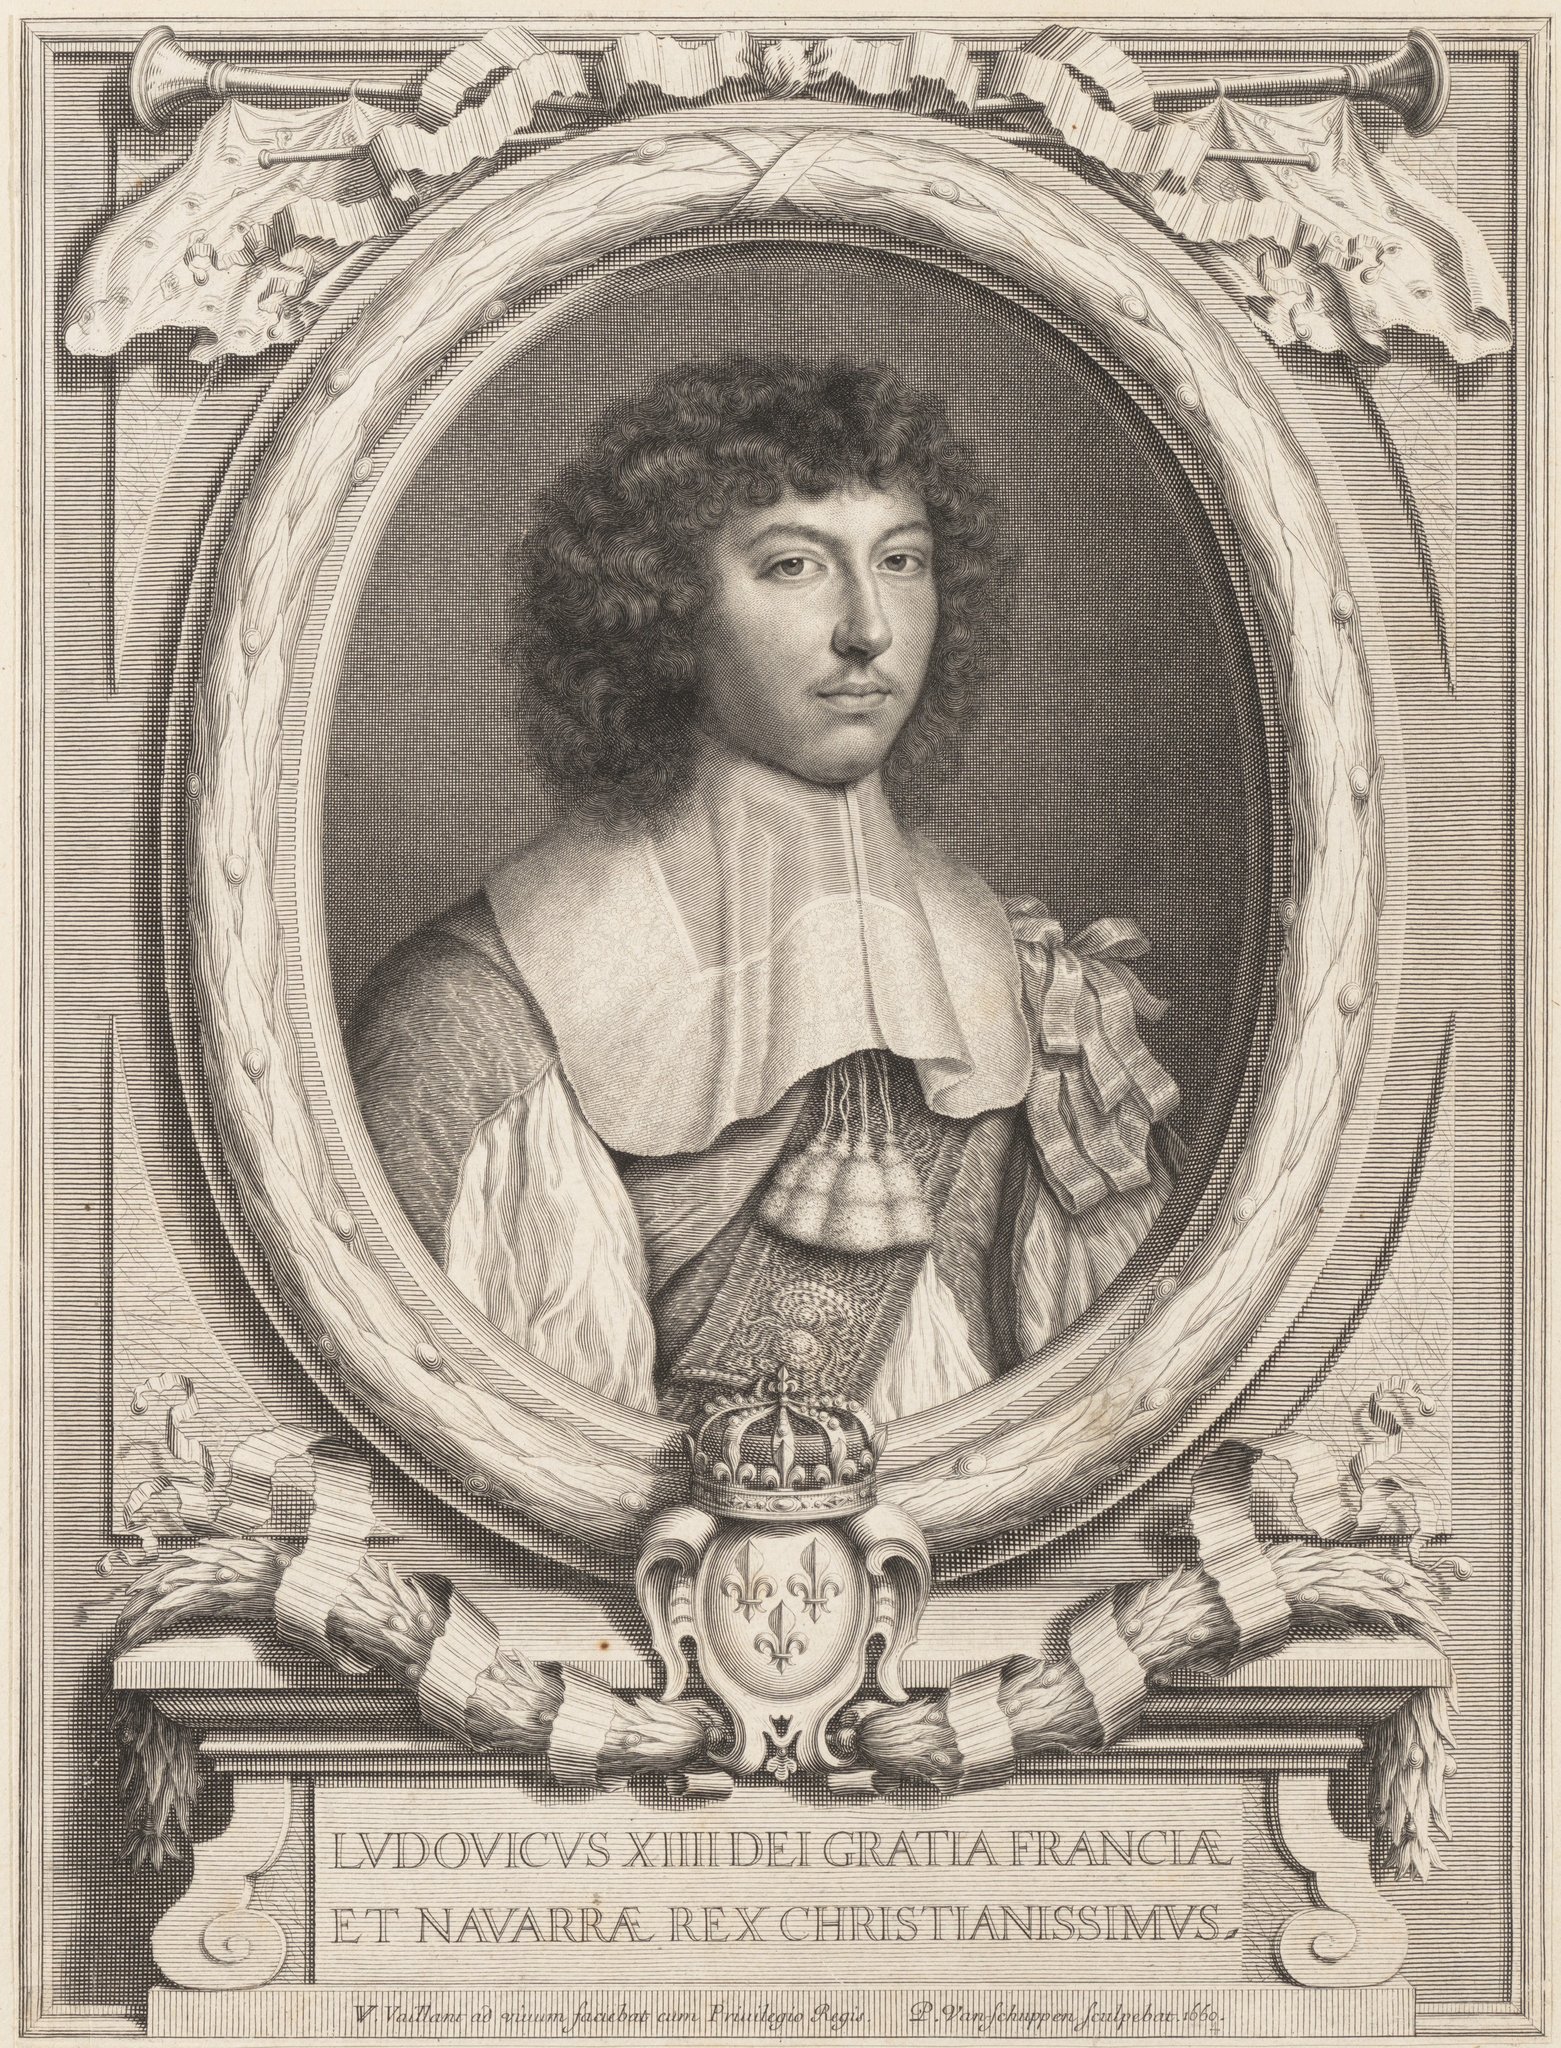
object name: print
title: Portrait of Louis XIV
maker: pieter van schuppen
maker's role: artist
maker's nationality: flemish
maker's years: 1627-1702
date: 1650-1702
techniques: engraving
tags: kings,louis xiv,portraits,coat of arms